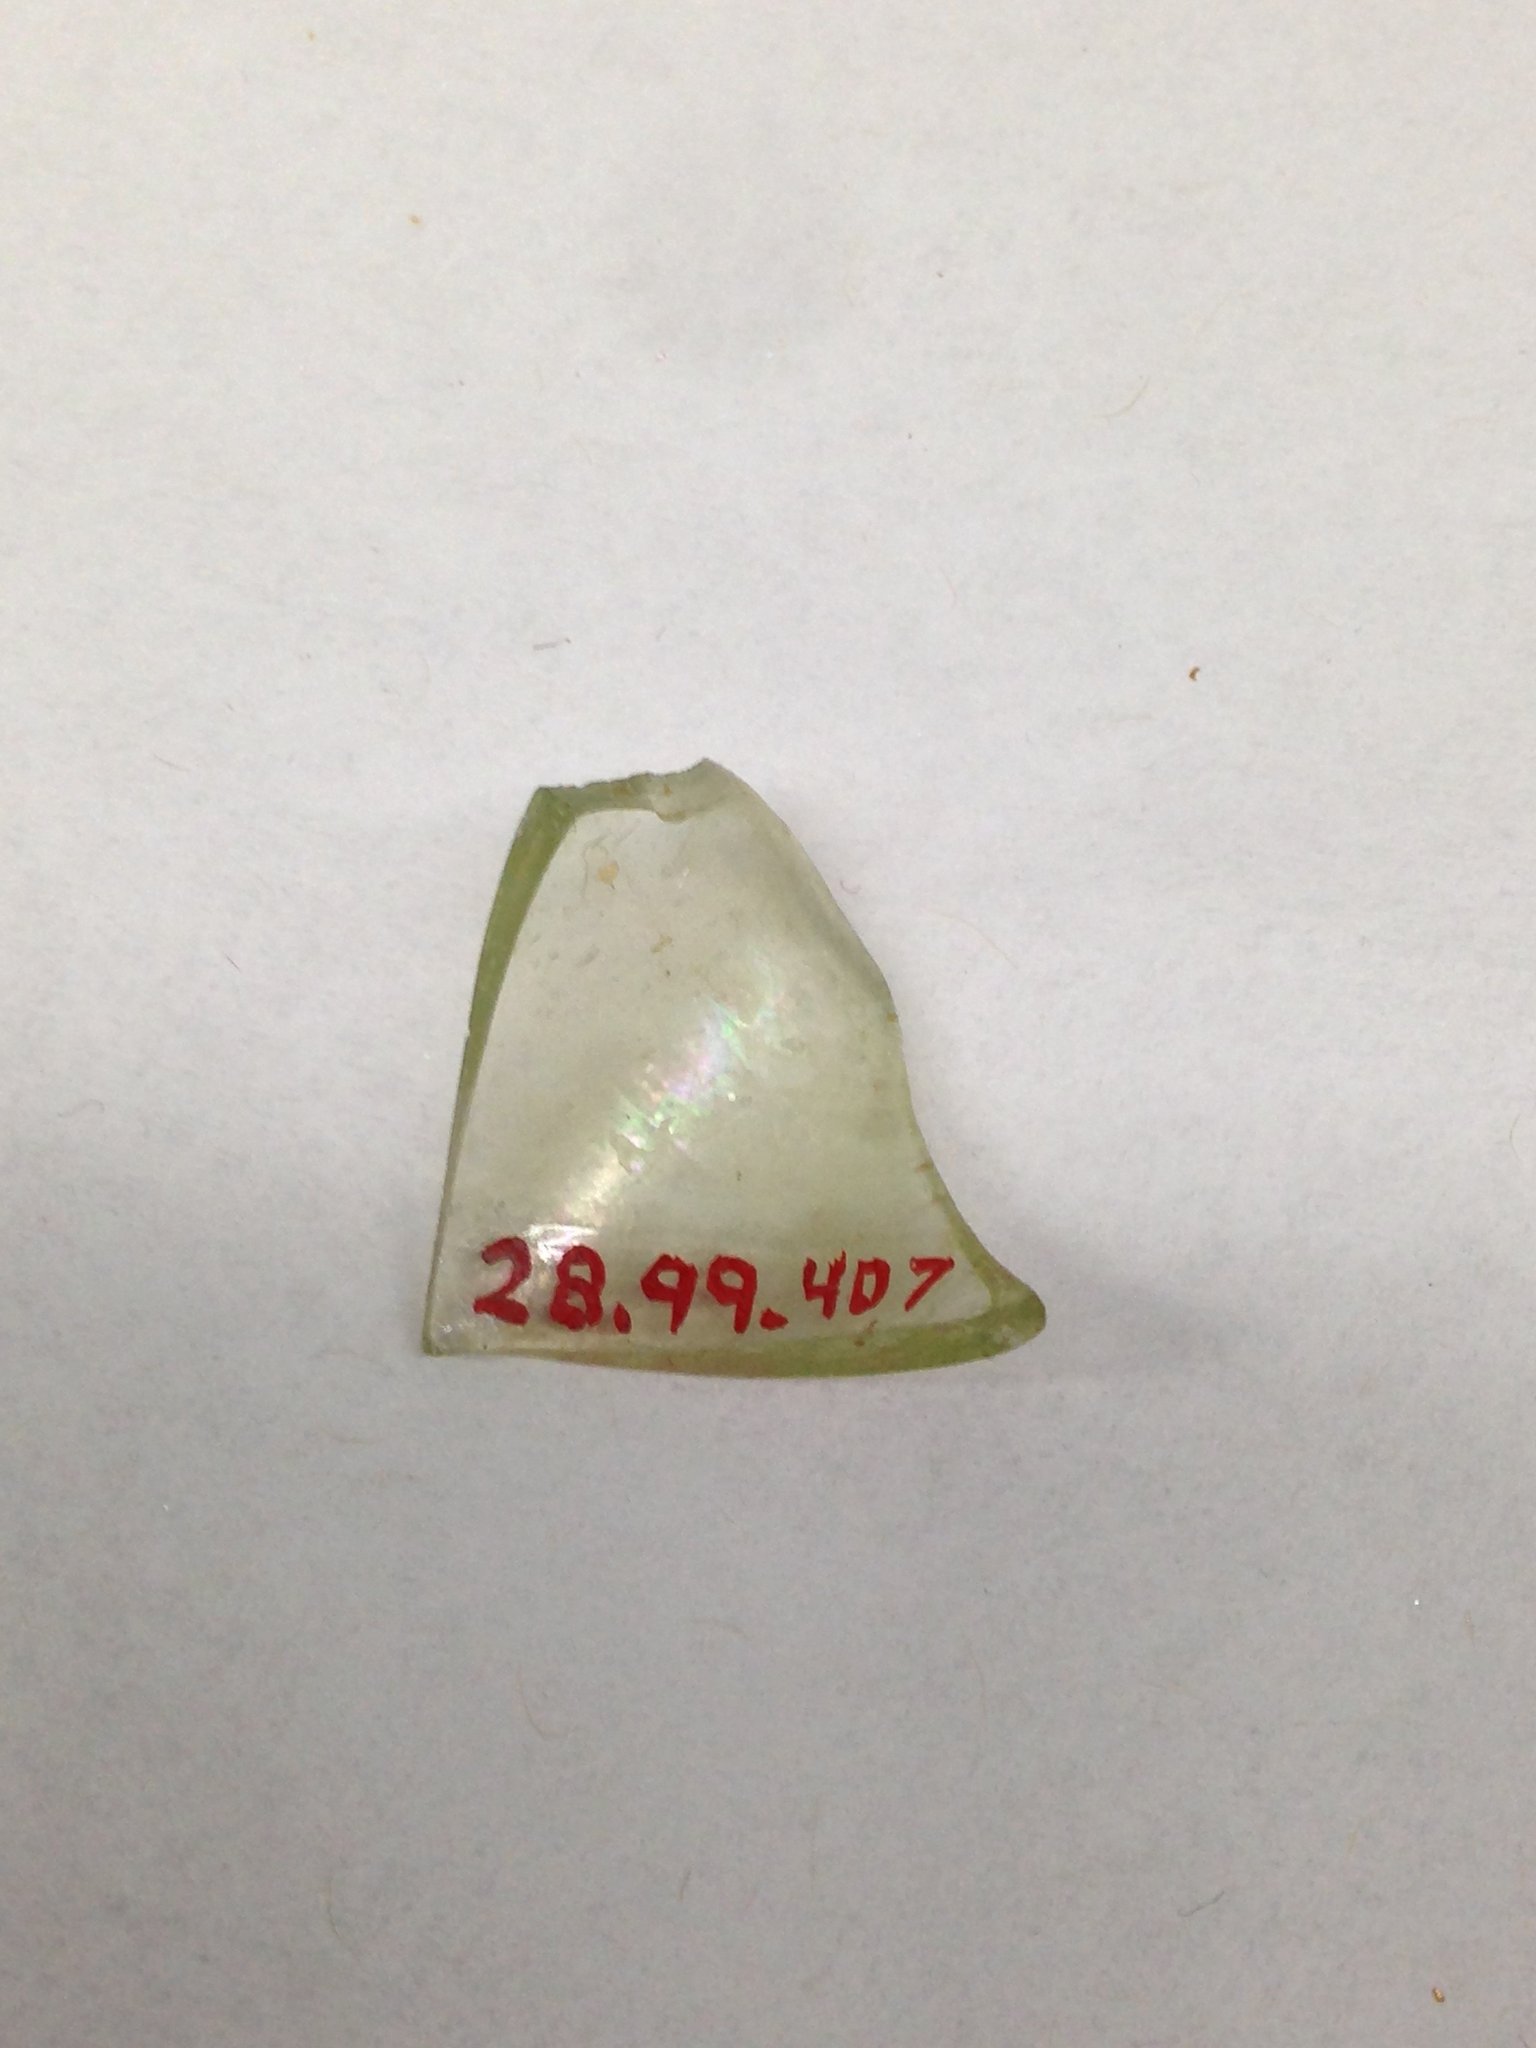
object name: fragment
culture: european or middle eastern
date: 1150-1250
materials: ceramic, glass